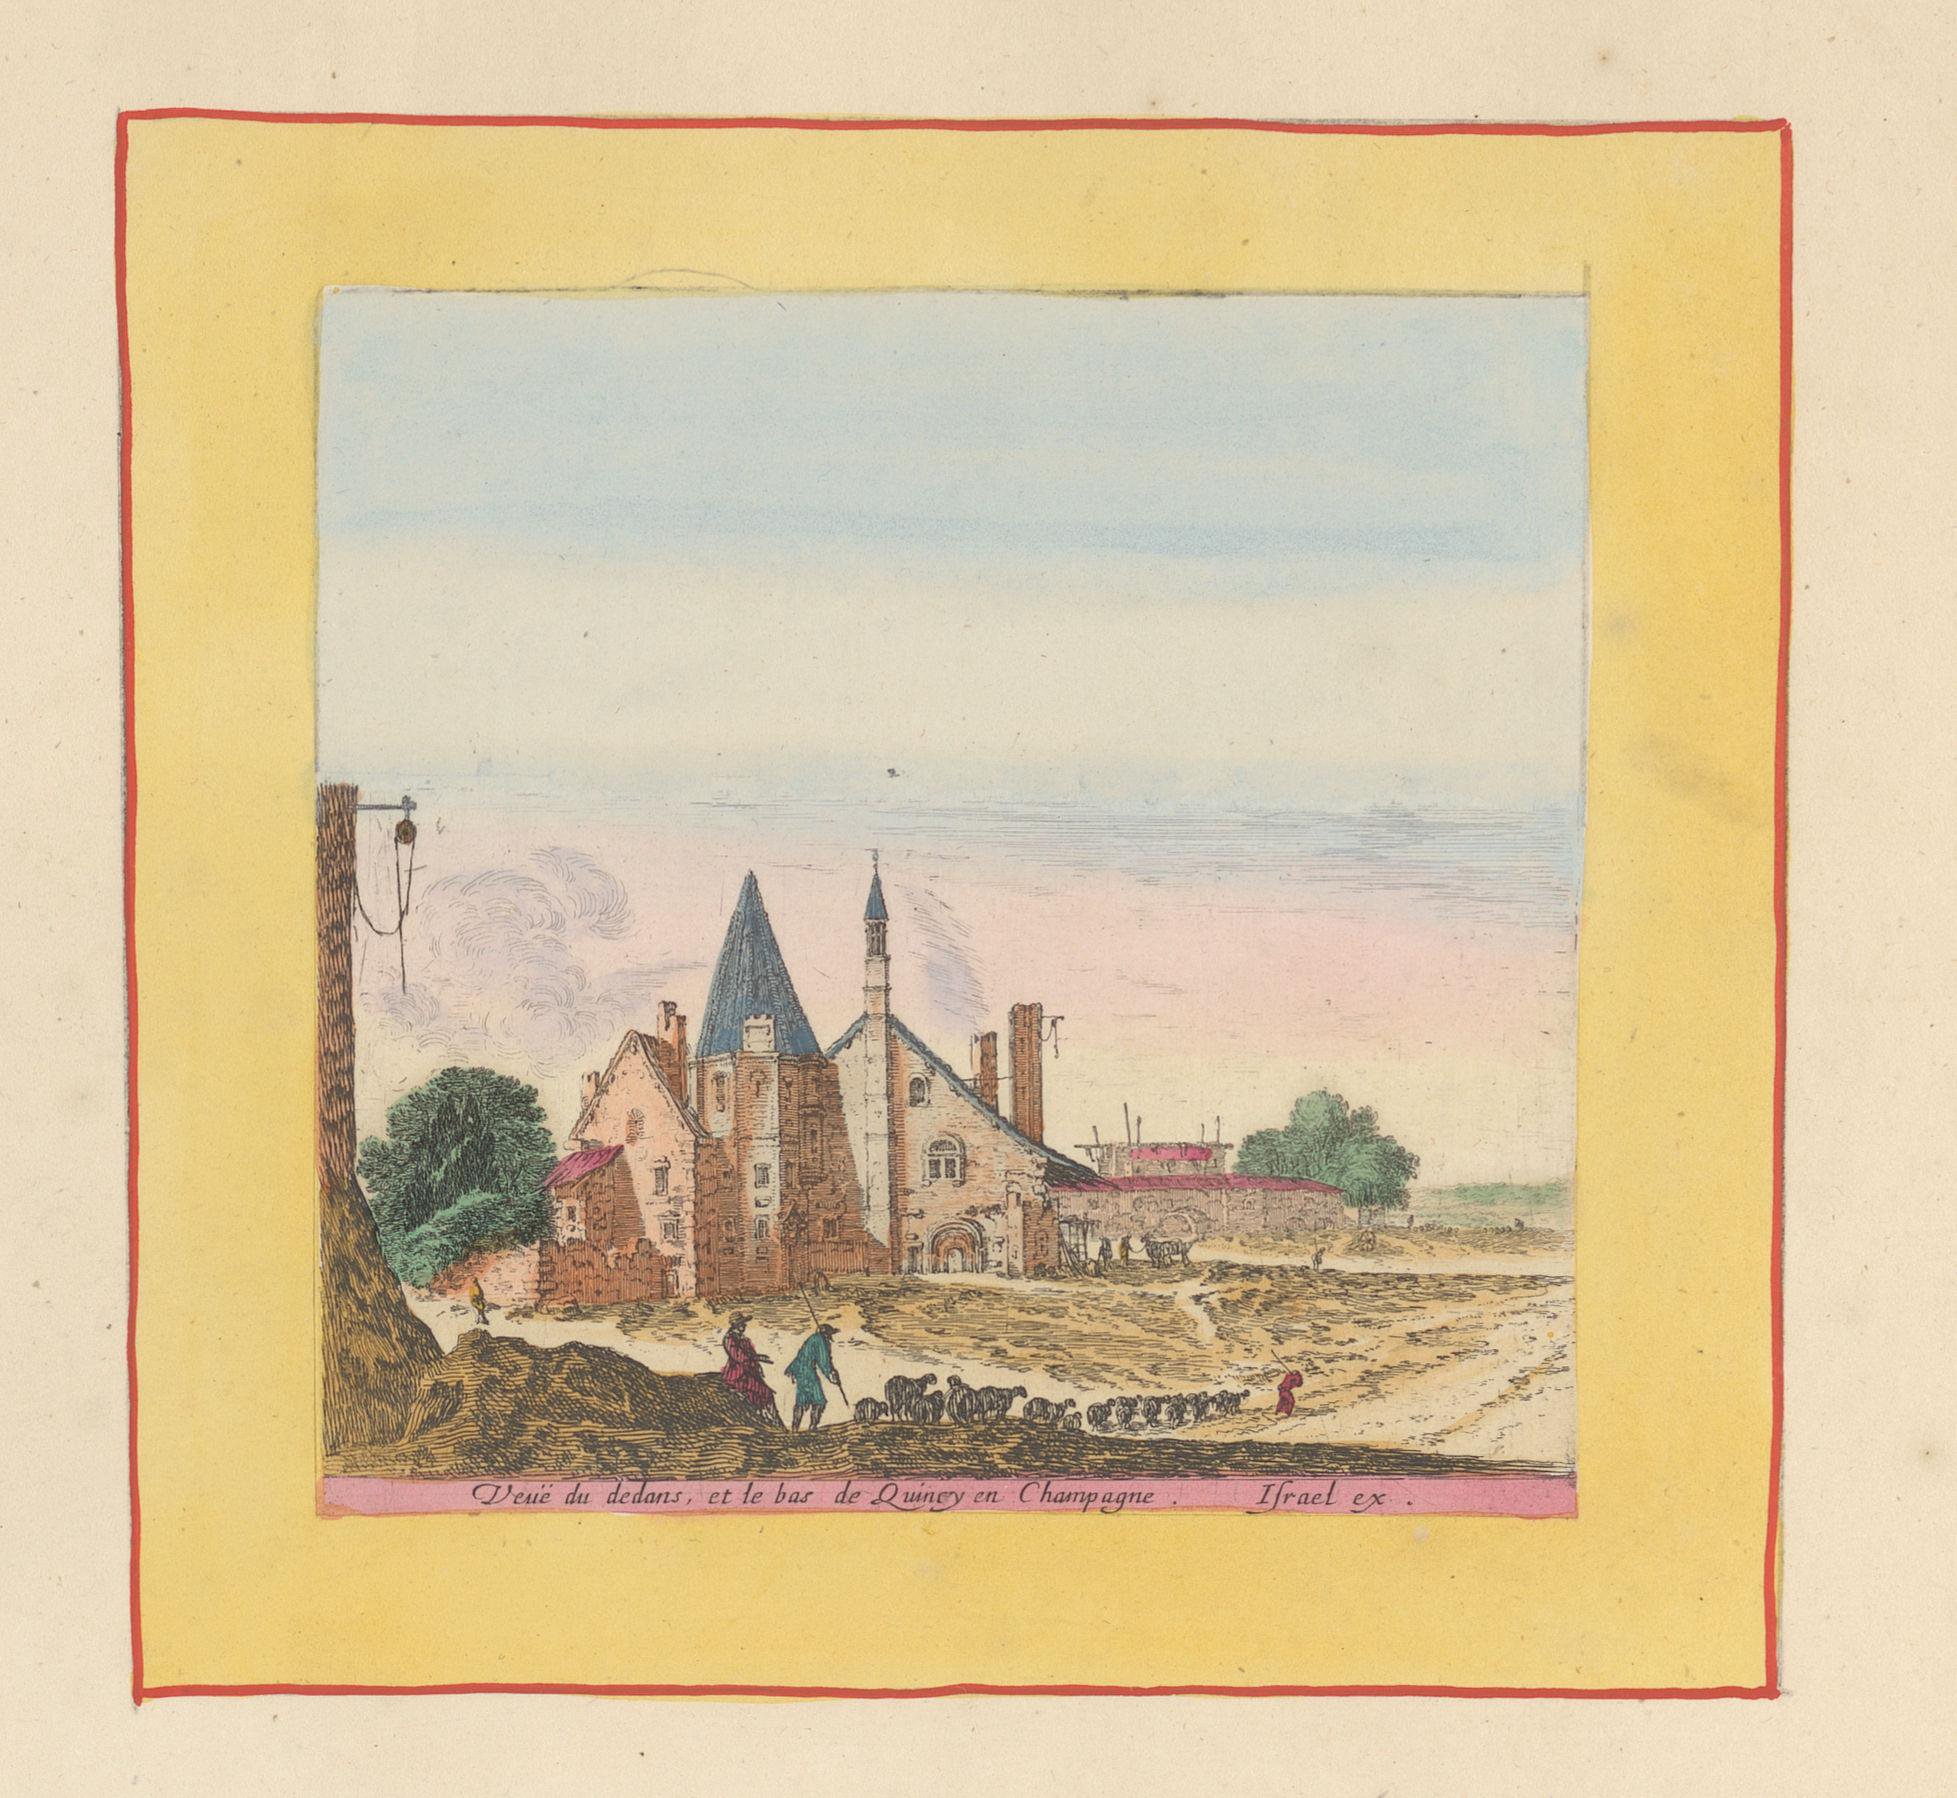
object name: print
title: Gezicht vanuit de abdij van Quincy met schaapsherder met kudde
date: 1631-1661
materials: paper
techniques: etching, hand coloring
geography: the hague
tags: city-view in general; 'veduta'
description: Deze prent maakt deel uit van een album.